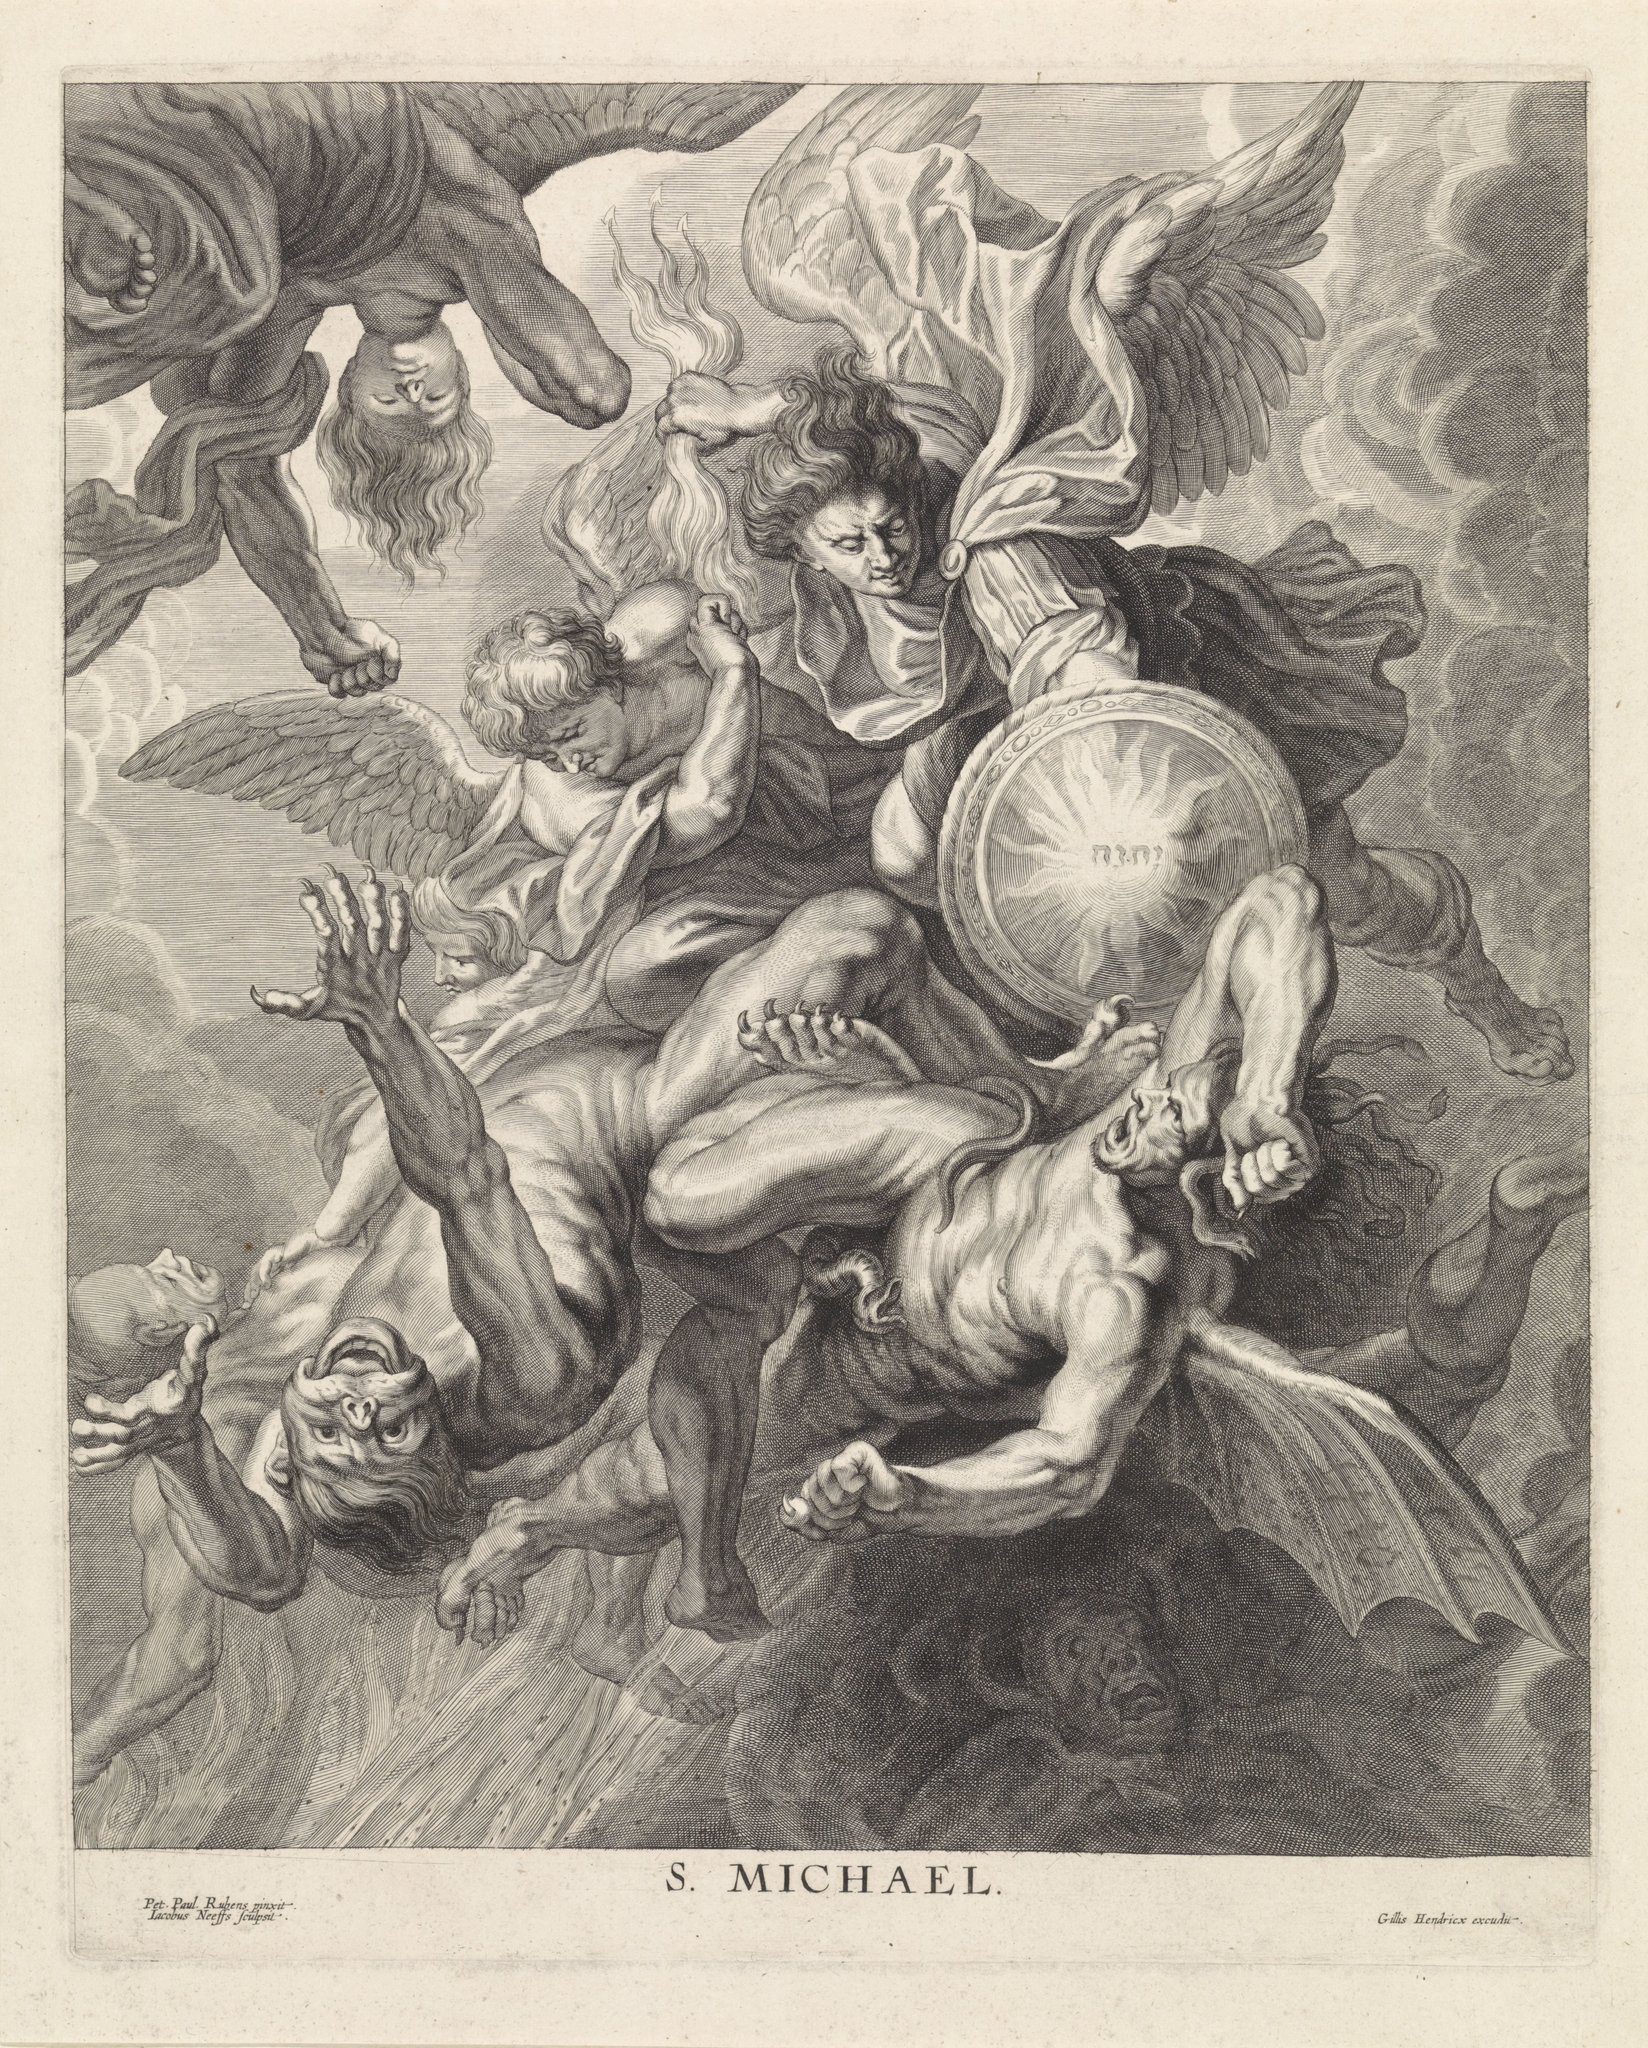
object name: print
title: Michaël en de val van de opstandige engelen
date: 1620-1680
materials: paper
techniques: engraving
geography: antwerp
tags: the archangel michael (and other angels) casting the rebel angels out of heaven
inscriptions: collector's mark: Lugt 240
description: De aartsengel Michaël, in zijn ene hand een schild met het symbool van God, in zijn andere hand een bundel vlammen, gooit samen met andere engelen de opstandige engelen uit de hemel.